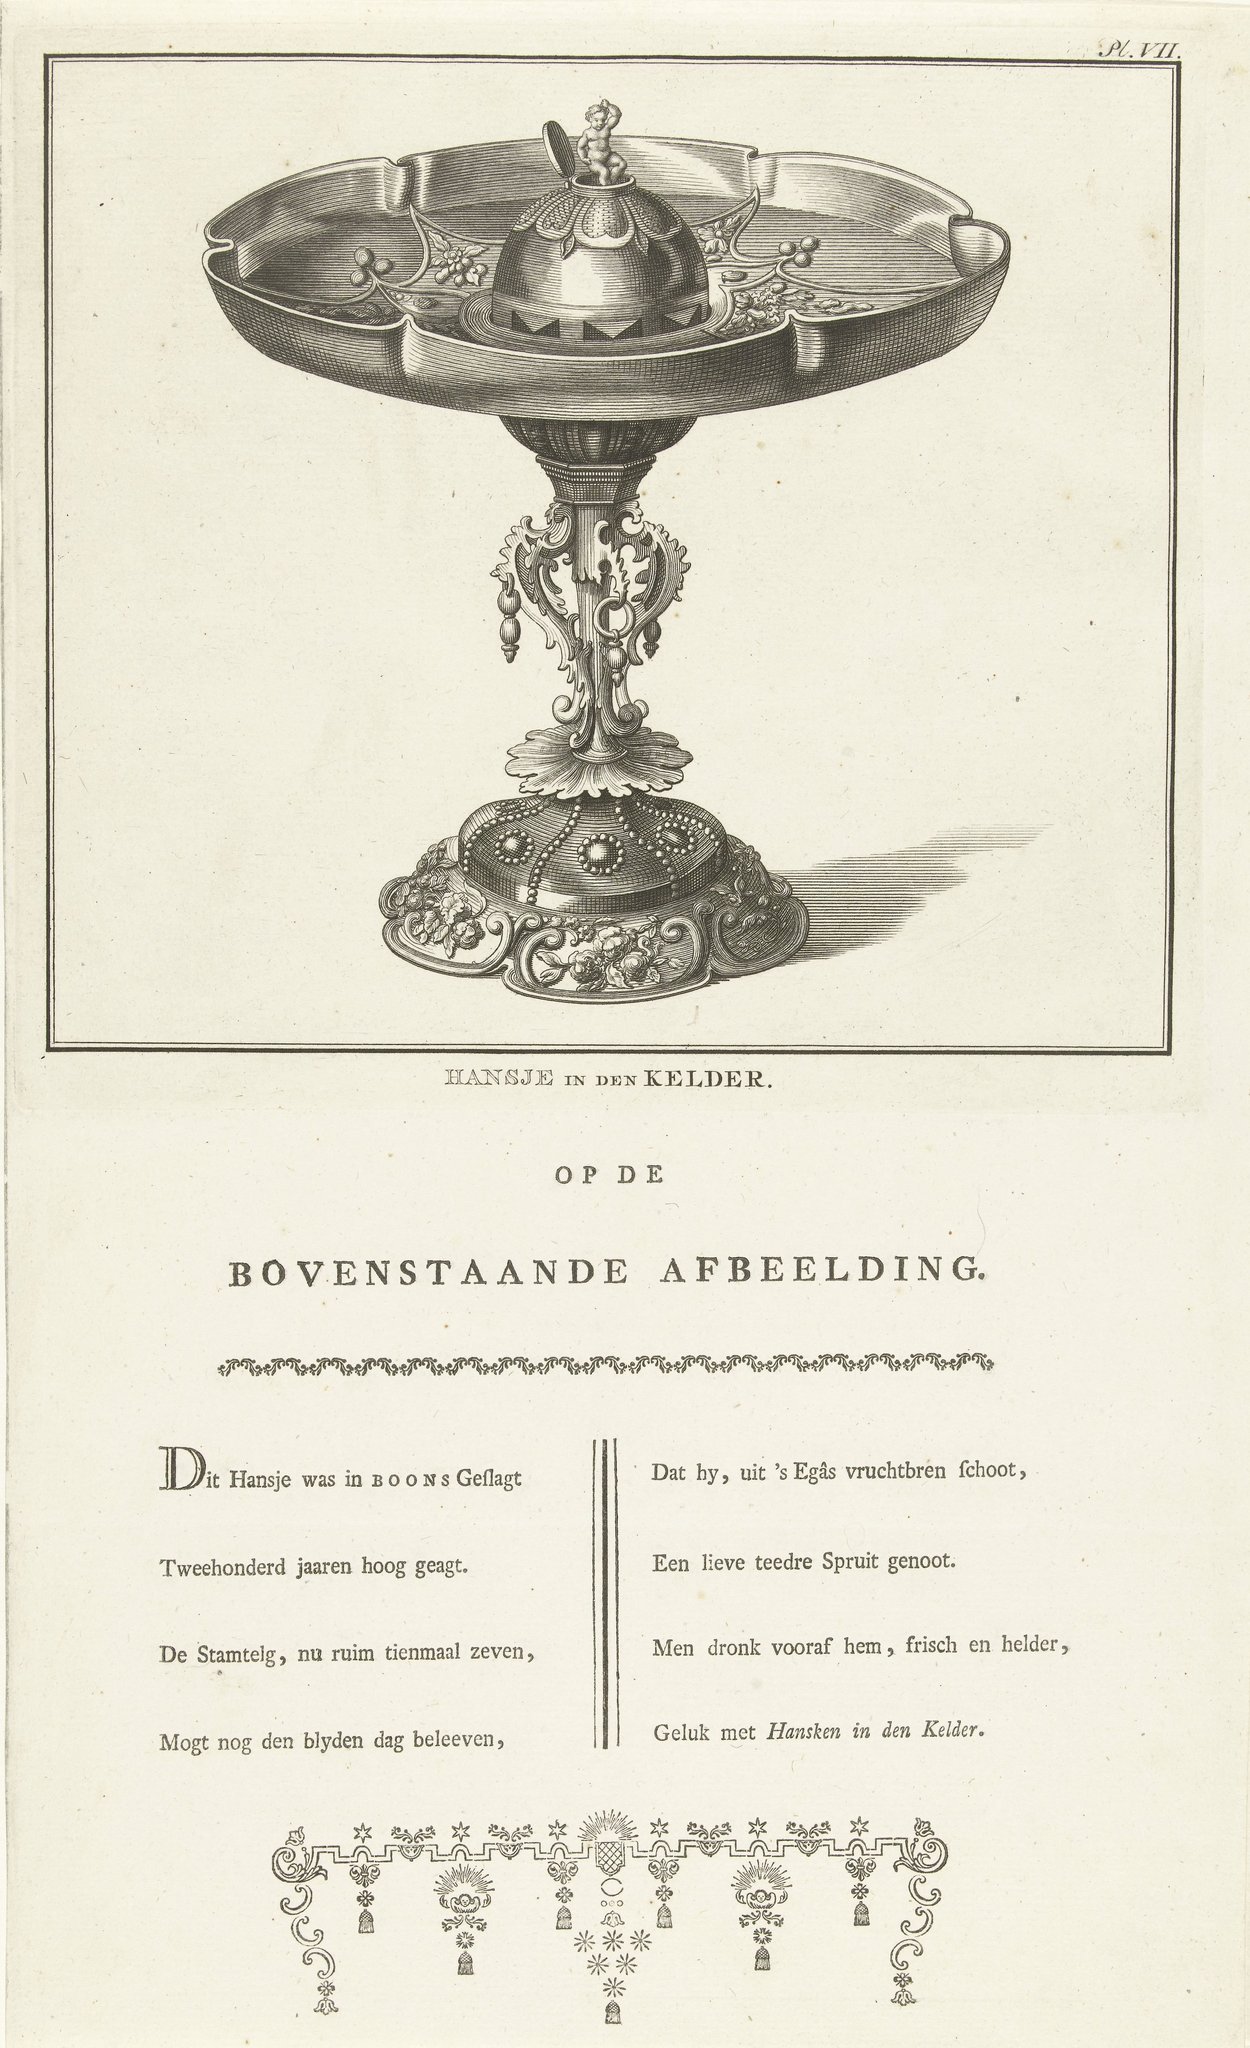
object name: print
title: Hansje in den Kelder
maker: Anonymous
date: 1774-1776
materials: paper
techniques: engraving, etching, letterpress printing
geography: northern netherlands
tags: drinking-vessel in unusual shape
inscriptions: collector's mark: Lugt 2228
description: Hansje-in-de-kelder uit de eerste helft 17de eeuw. Drinkschaal van zilver versierd met vruchttrossen en met in het midden een halve bol met opklapbare deksel waaronder een verguld kinderfiguur is verborgen. Op het blad onder de plaat een achtregelig vers op de heer Cornelis Boon te Warmond in wiens familie deze drinkschaal in 1770 al 200 jaar berustte en die nog ruim na zijn zeventigste vader is geworden. Rechtsboven in de plaat gemerkt: Pl. VII.